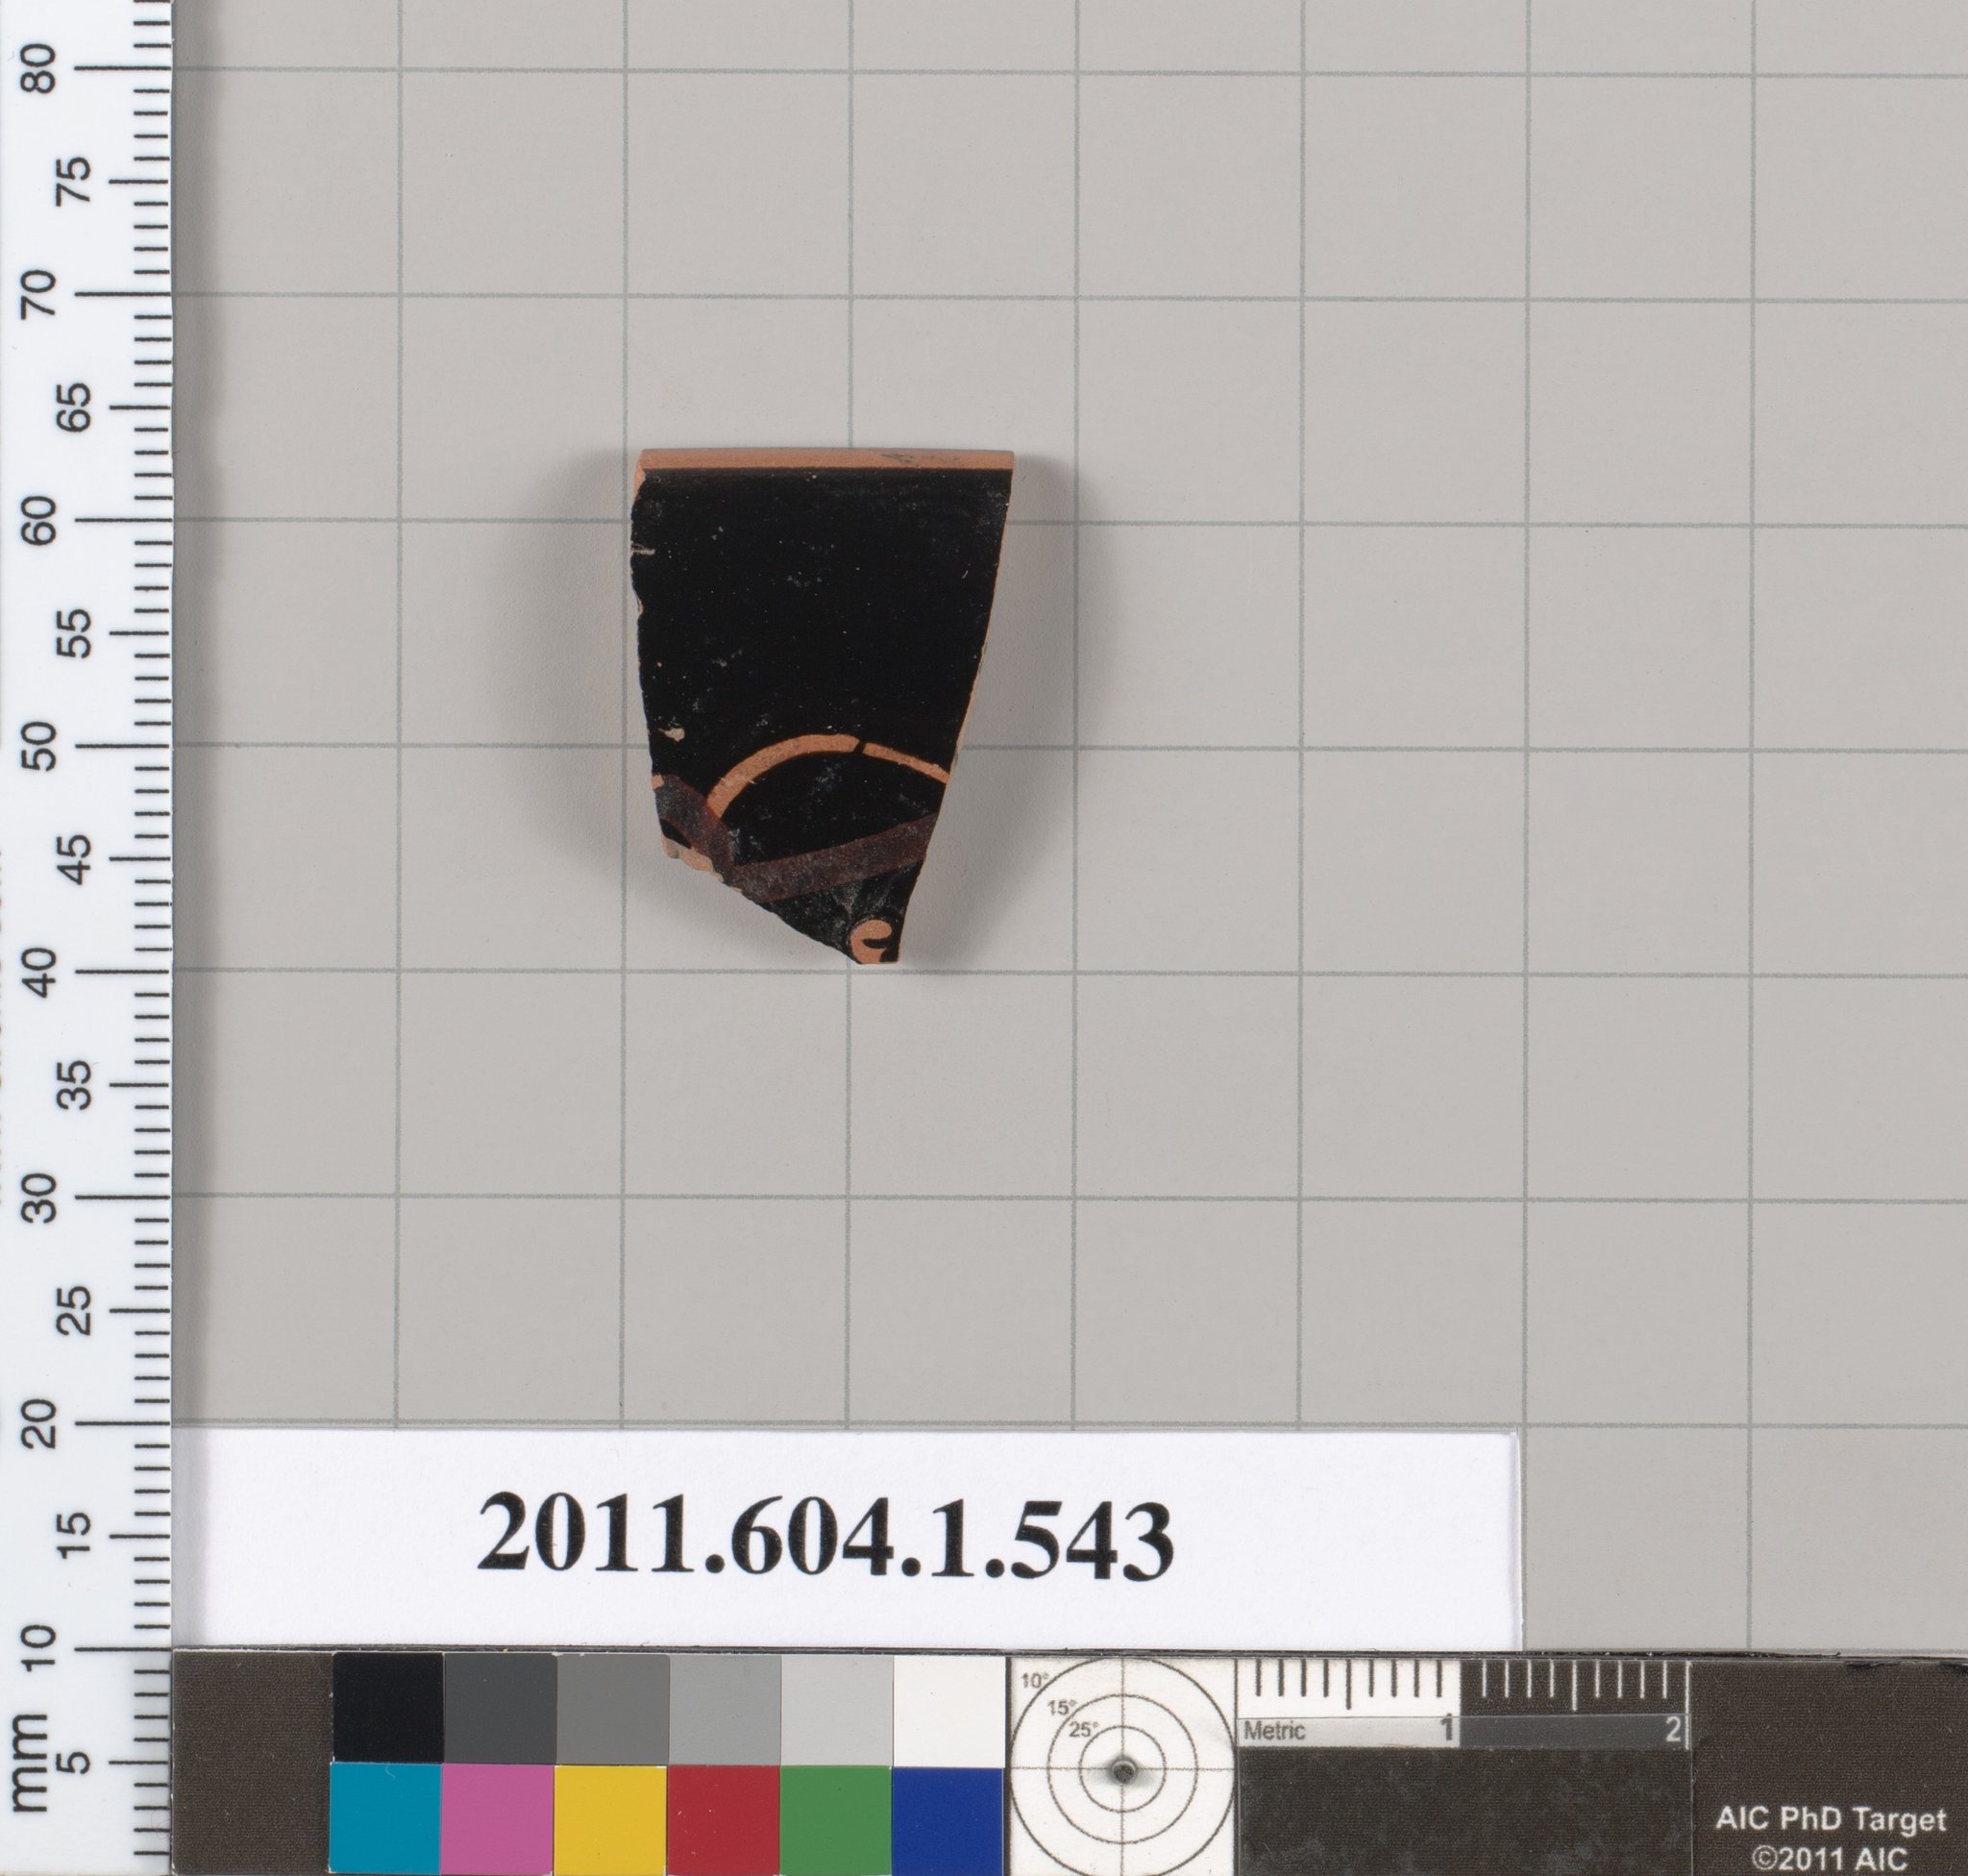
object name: kylix fragment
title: Terracotta rim fragment of a kylix (drinking cup)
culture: greek, attic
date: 480-470 BCE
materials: terracotta